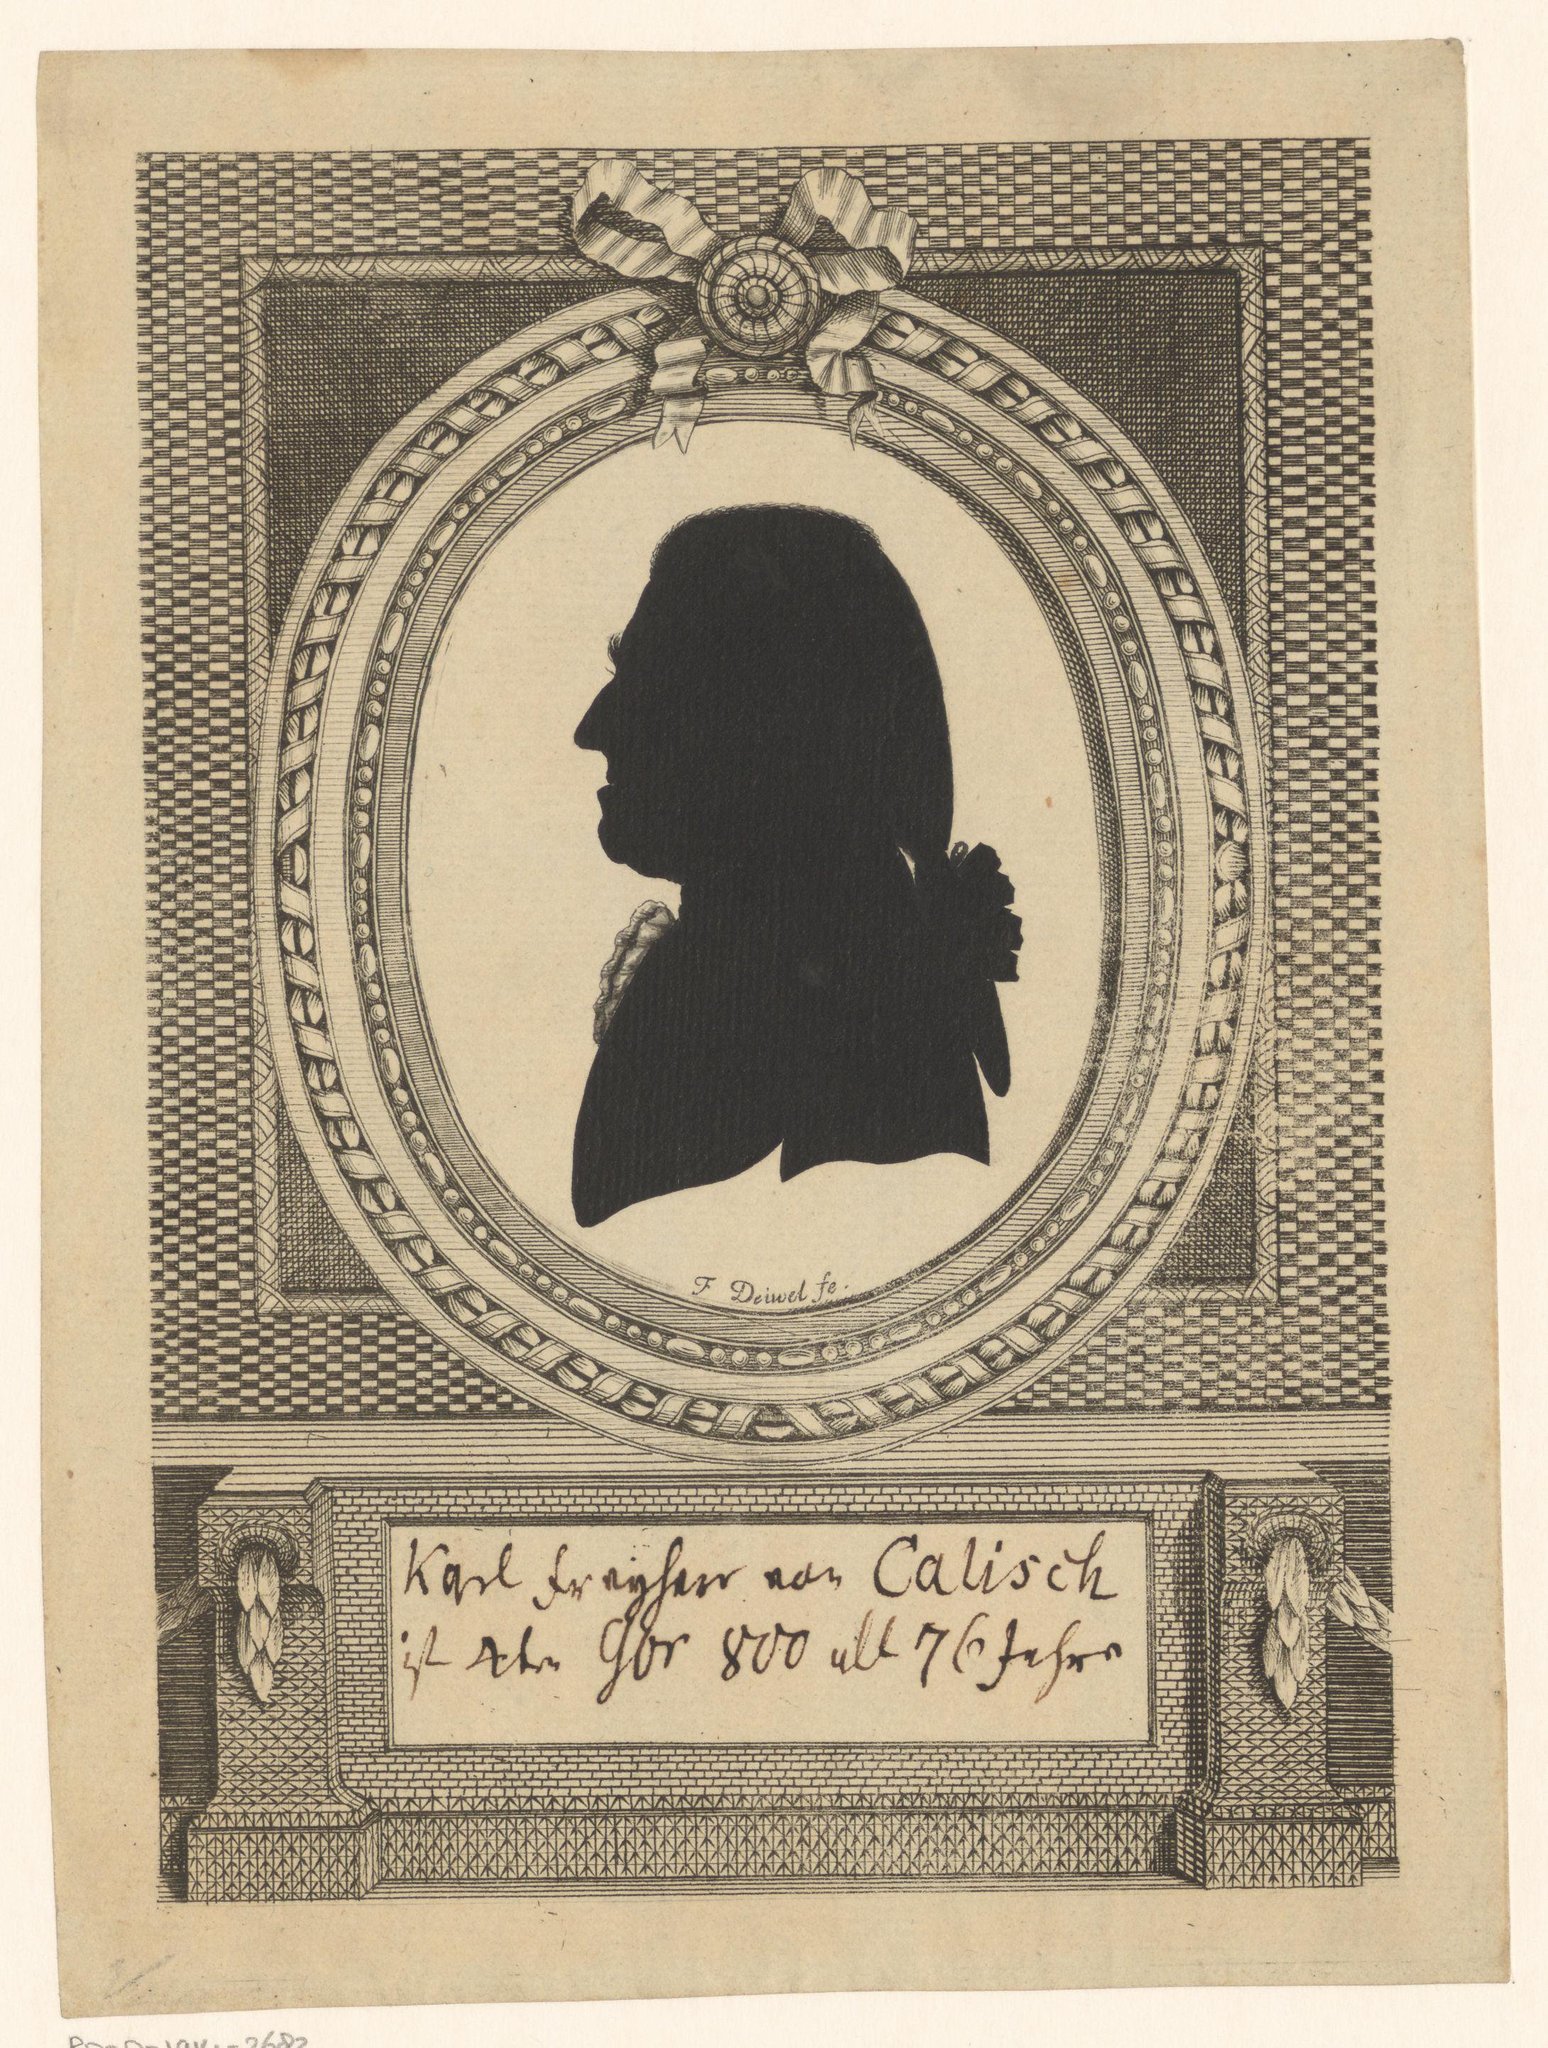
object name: print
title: Silhouet van Karl Freyherr von Calisch op 76-jarige leeftijd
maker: franz deiwel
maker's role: silhouettist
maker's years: 1748-1810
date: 1758-1810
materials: paper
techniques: engraving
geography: austria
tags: ornament ~ medallion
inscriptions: collector's mark: Lugt 2228, inscription: ‘Naam en leeftijd van de geportretteerde’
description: Het onderschrift is enigszins slordig met de hand geschreven op het basement van de architecturale omlijsting.